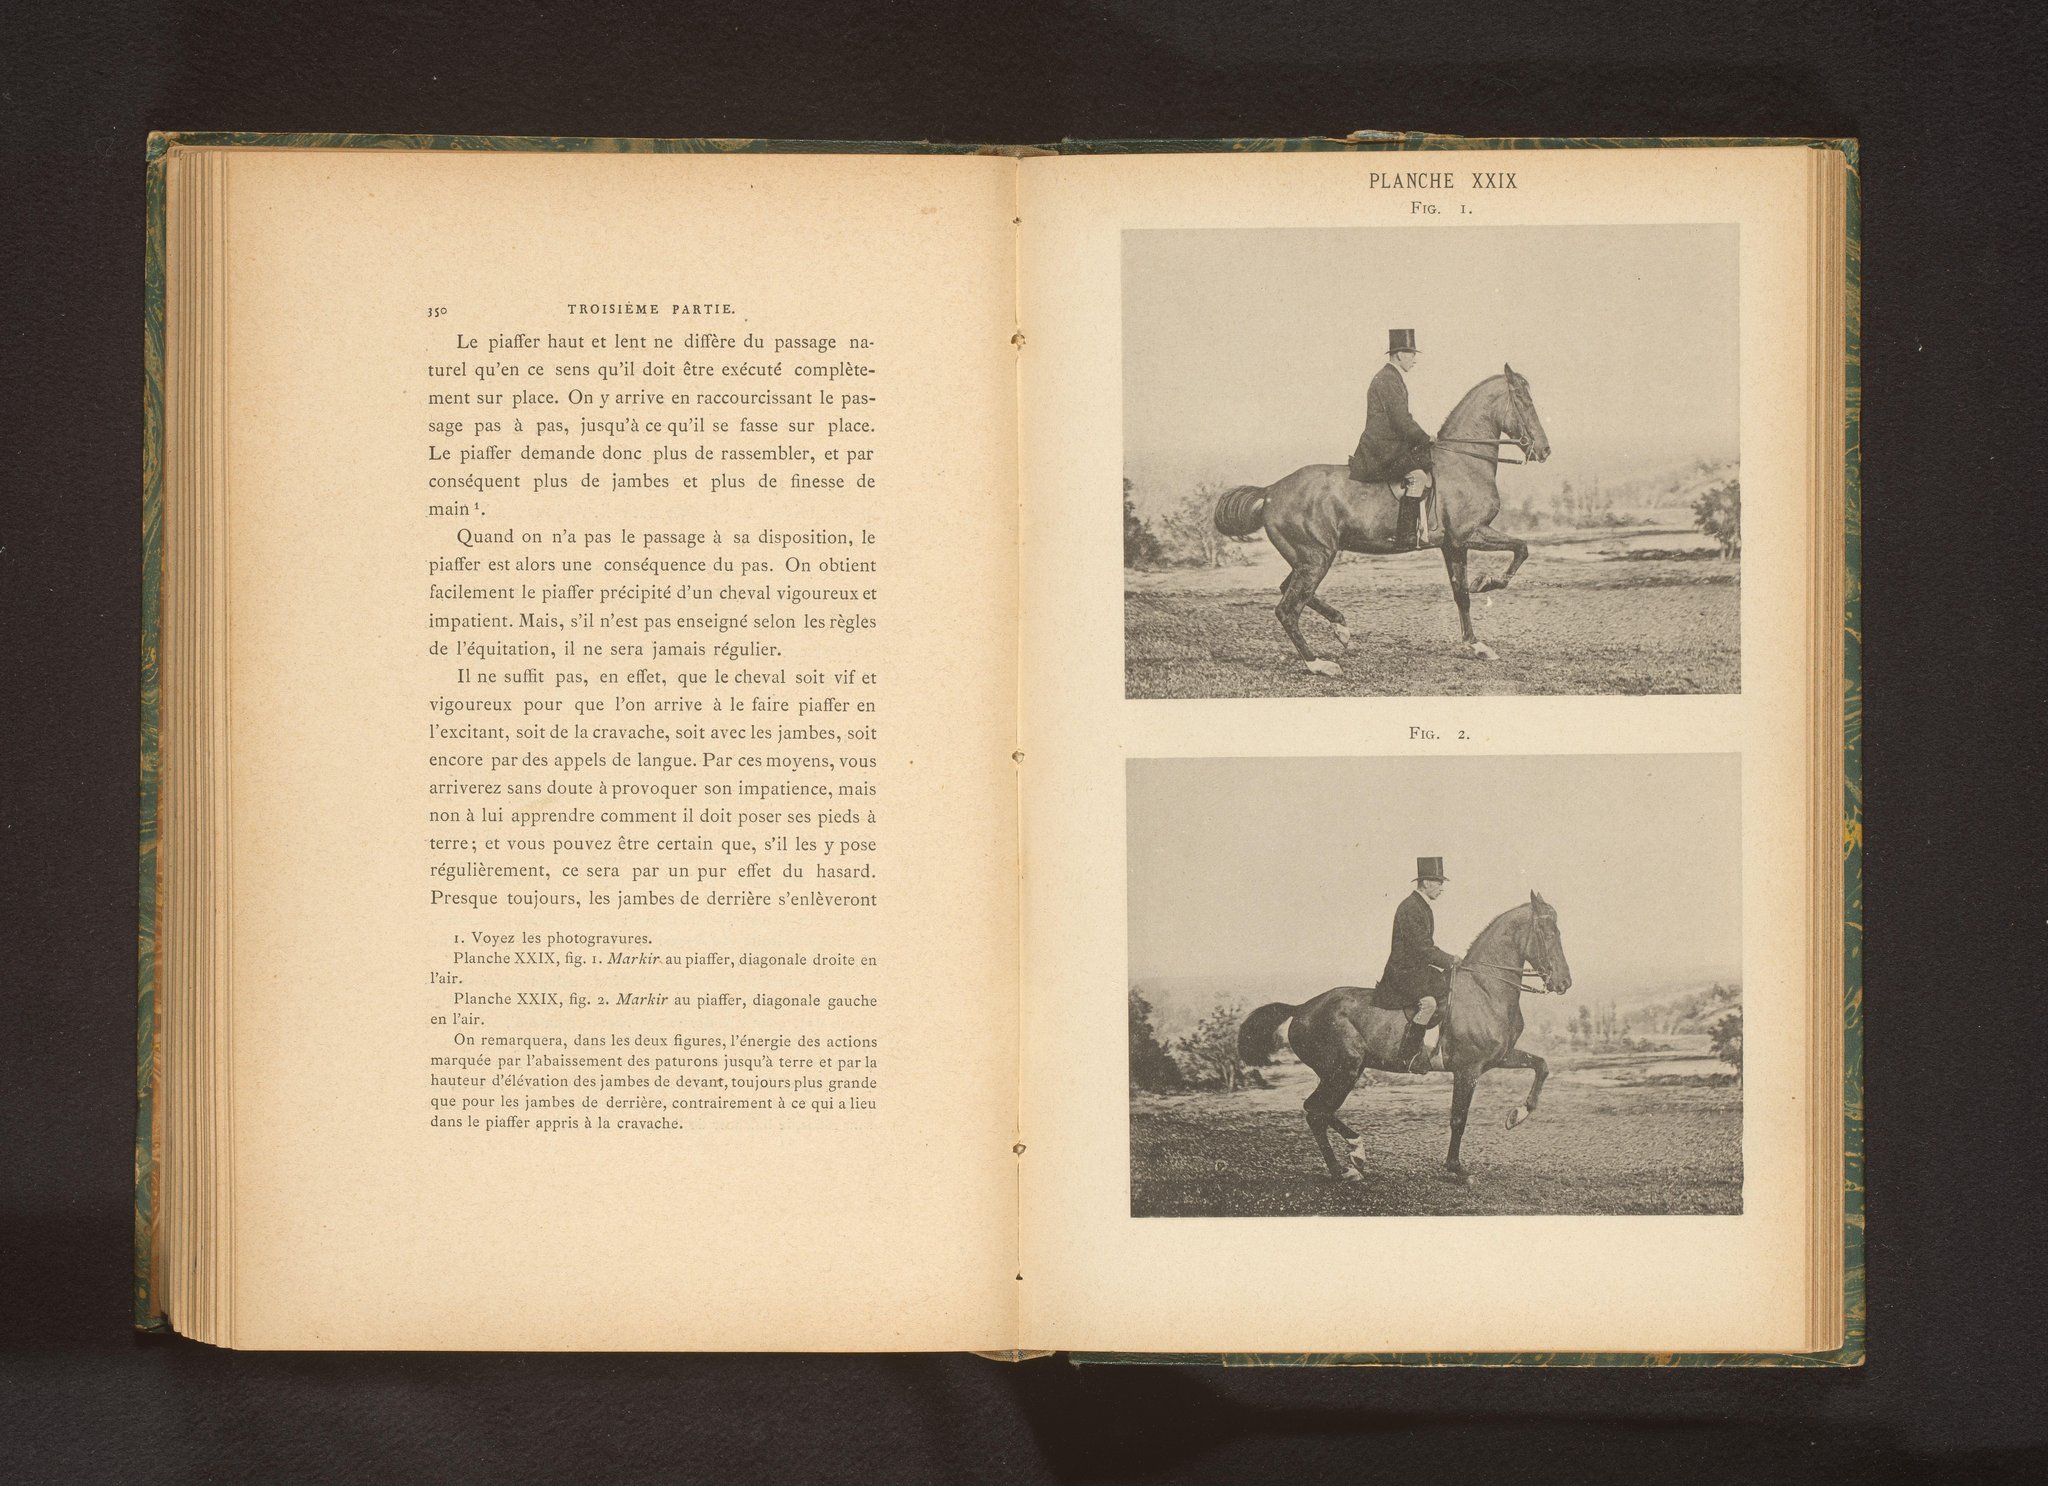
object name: photomechanical print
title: Twee mannen op paarden in piaffe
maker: jean delton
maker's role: fotograaf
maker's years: 1850-1901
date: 1882-1892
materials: paper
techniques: photograph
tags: riding a horse, ass, or mule; rider, horseman, head-gear: top hat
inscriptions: number: ‘Planche XXIX Fig. 1. Fig. 2.’